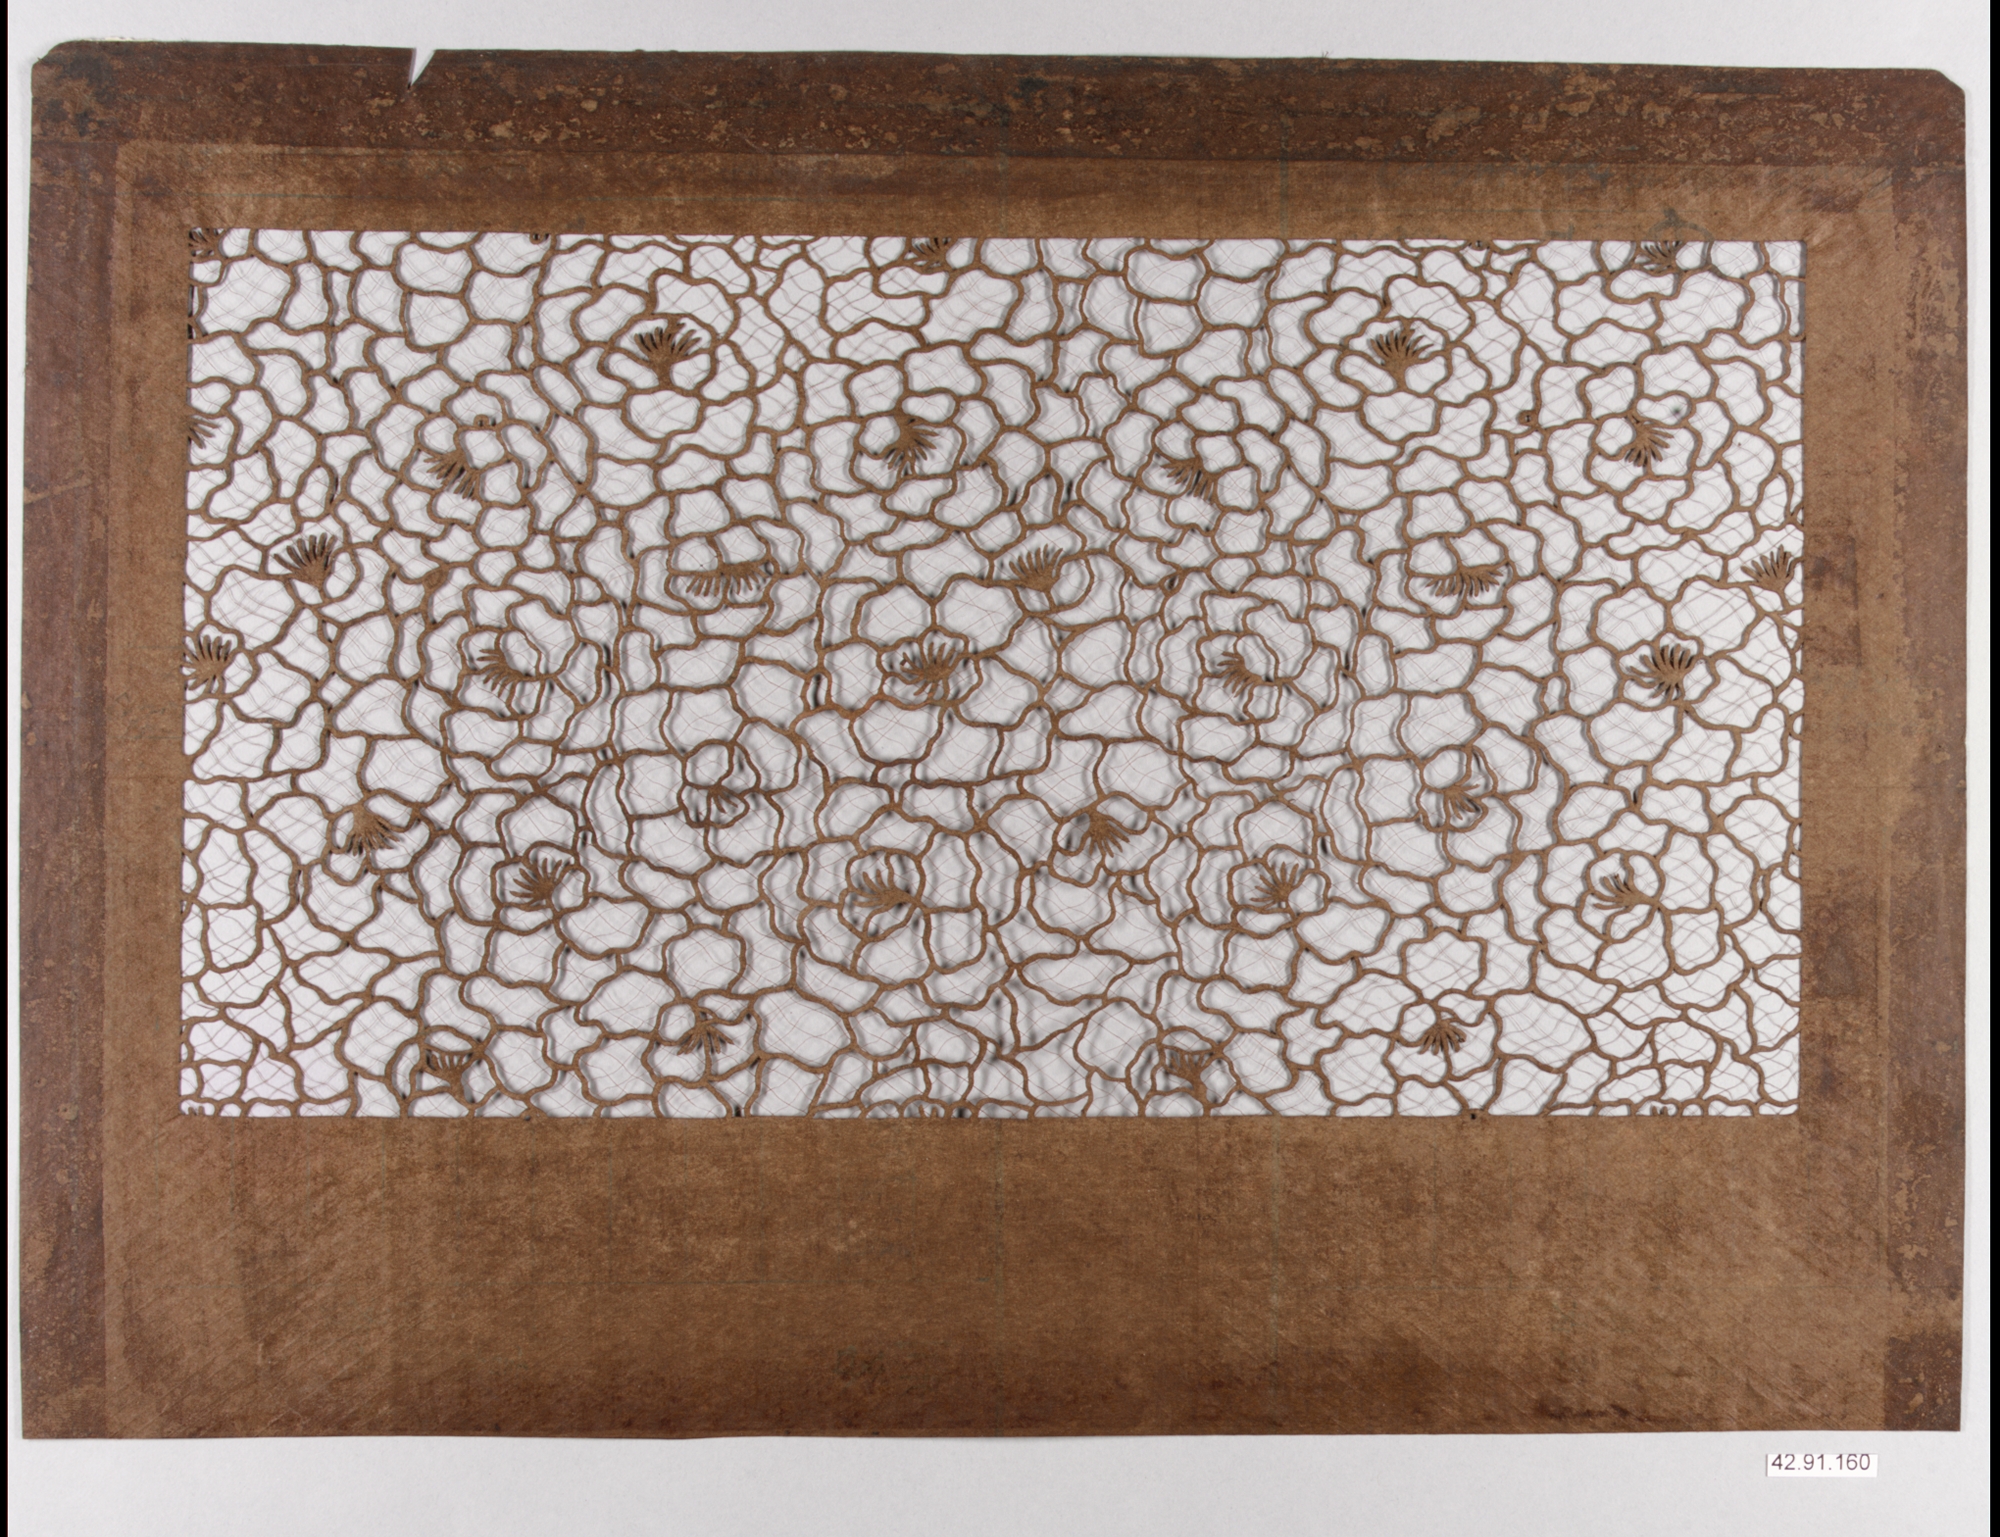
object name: stencil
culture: japanese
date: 1801-1900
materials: paper